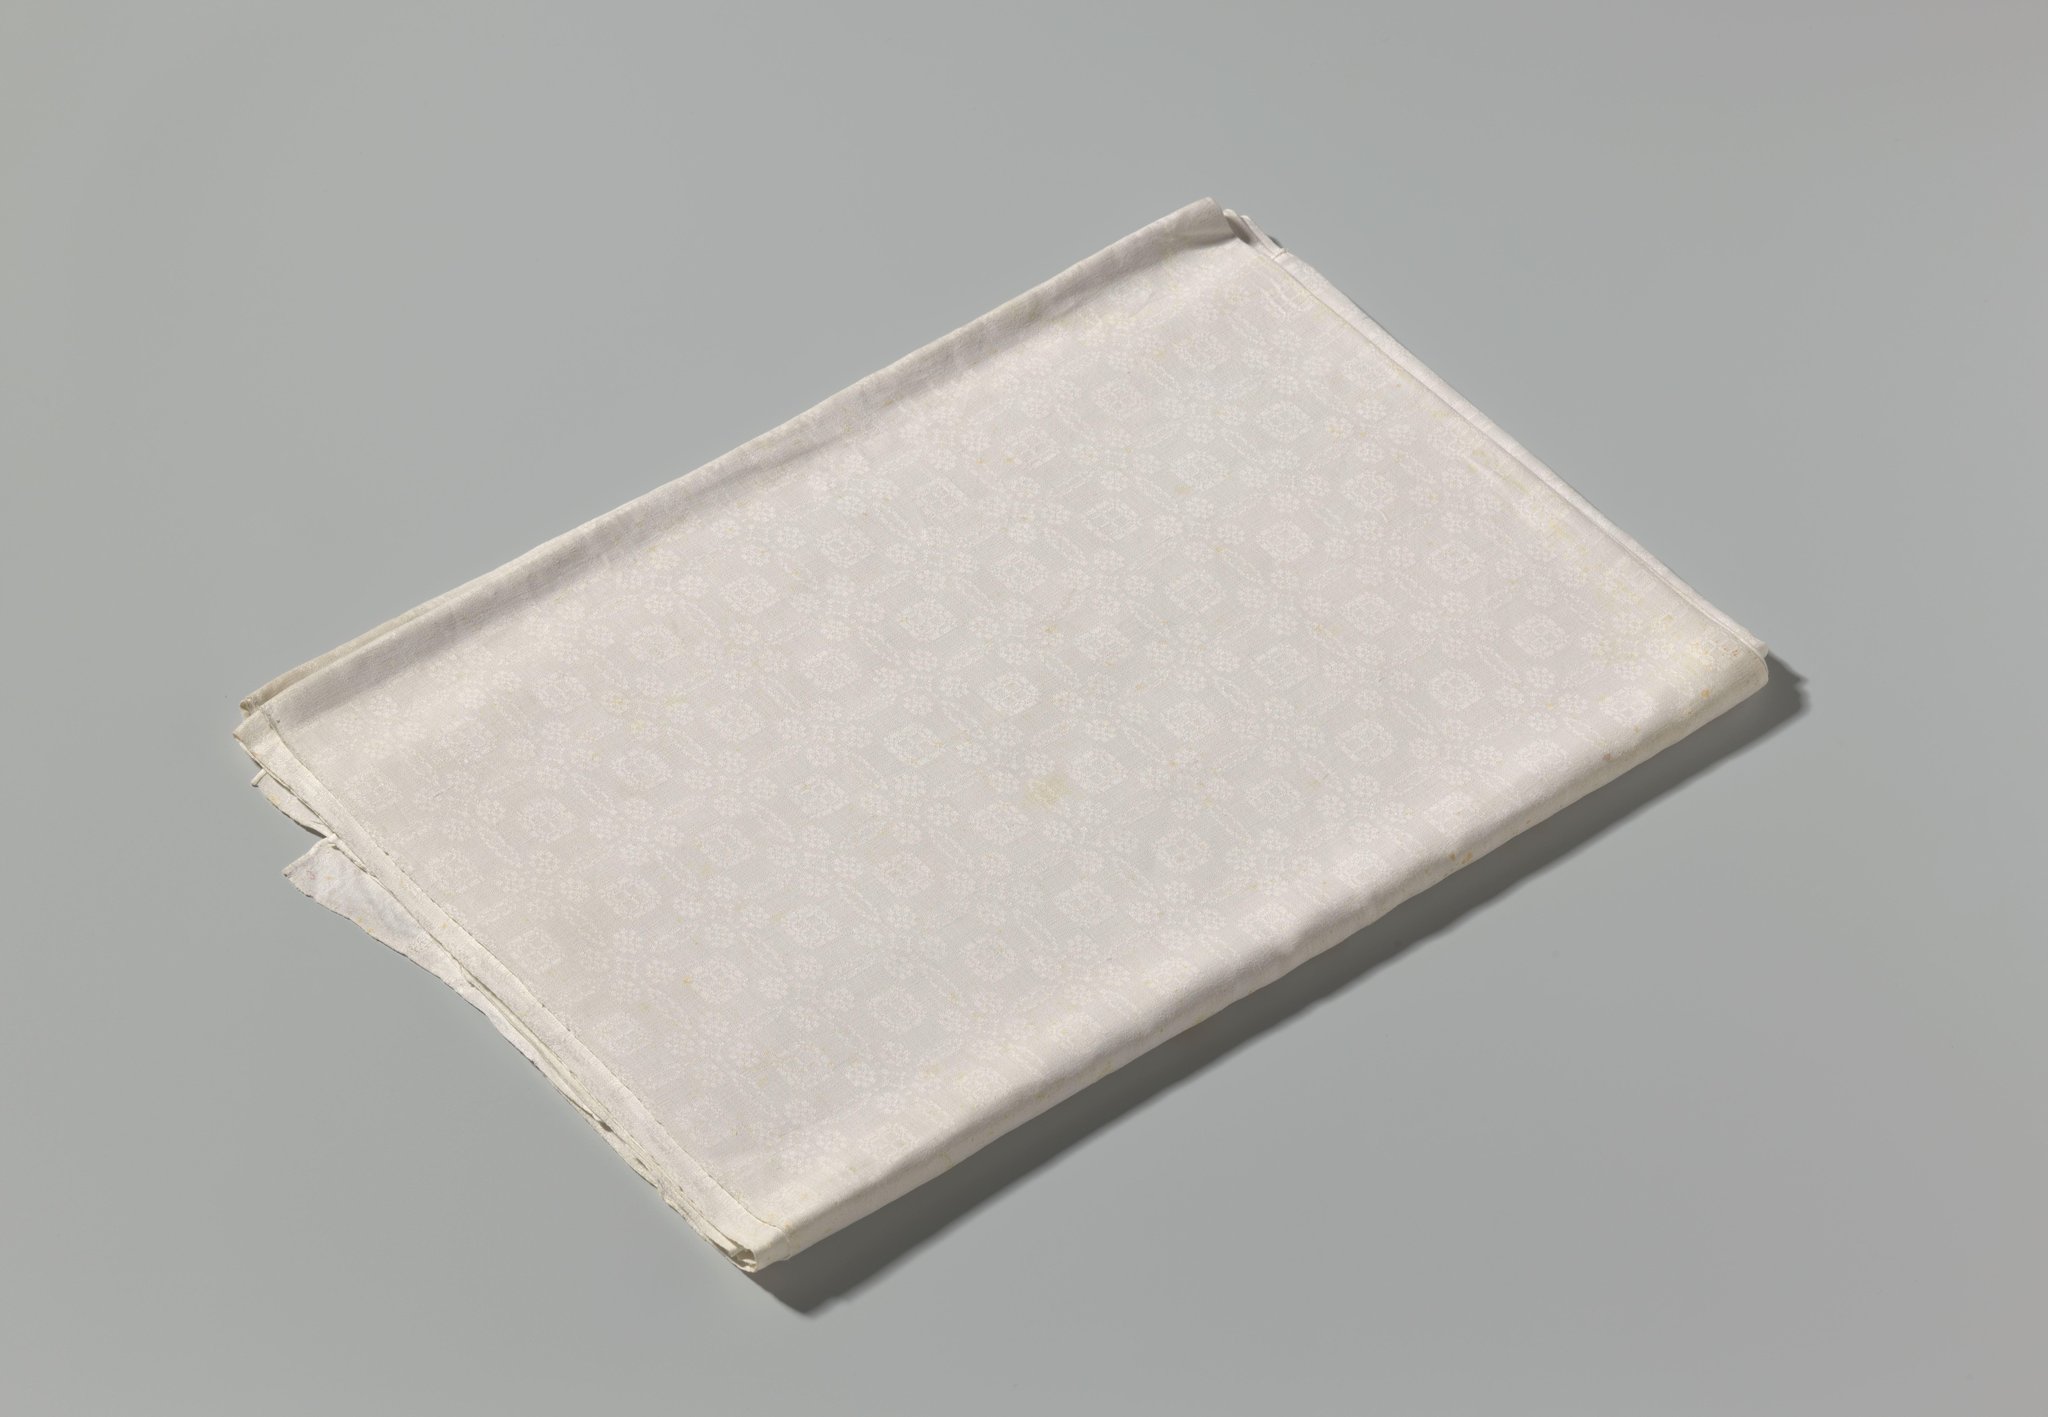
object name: tablecloth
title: Tafellaken van pellendamast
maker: Anonymous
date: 1700-1800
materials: linen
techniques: cross stitching, weave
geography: northern netherlands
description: Tafellaken van linnen pellendamast. Lijnen van gestileerde rozetten en ellipsen vormen vierkanten waarbinnen een geblokt vierkant. Het laken is in rood met een kruisteek gemerkt: LD 3.